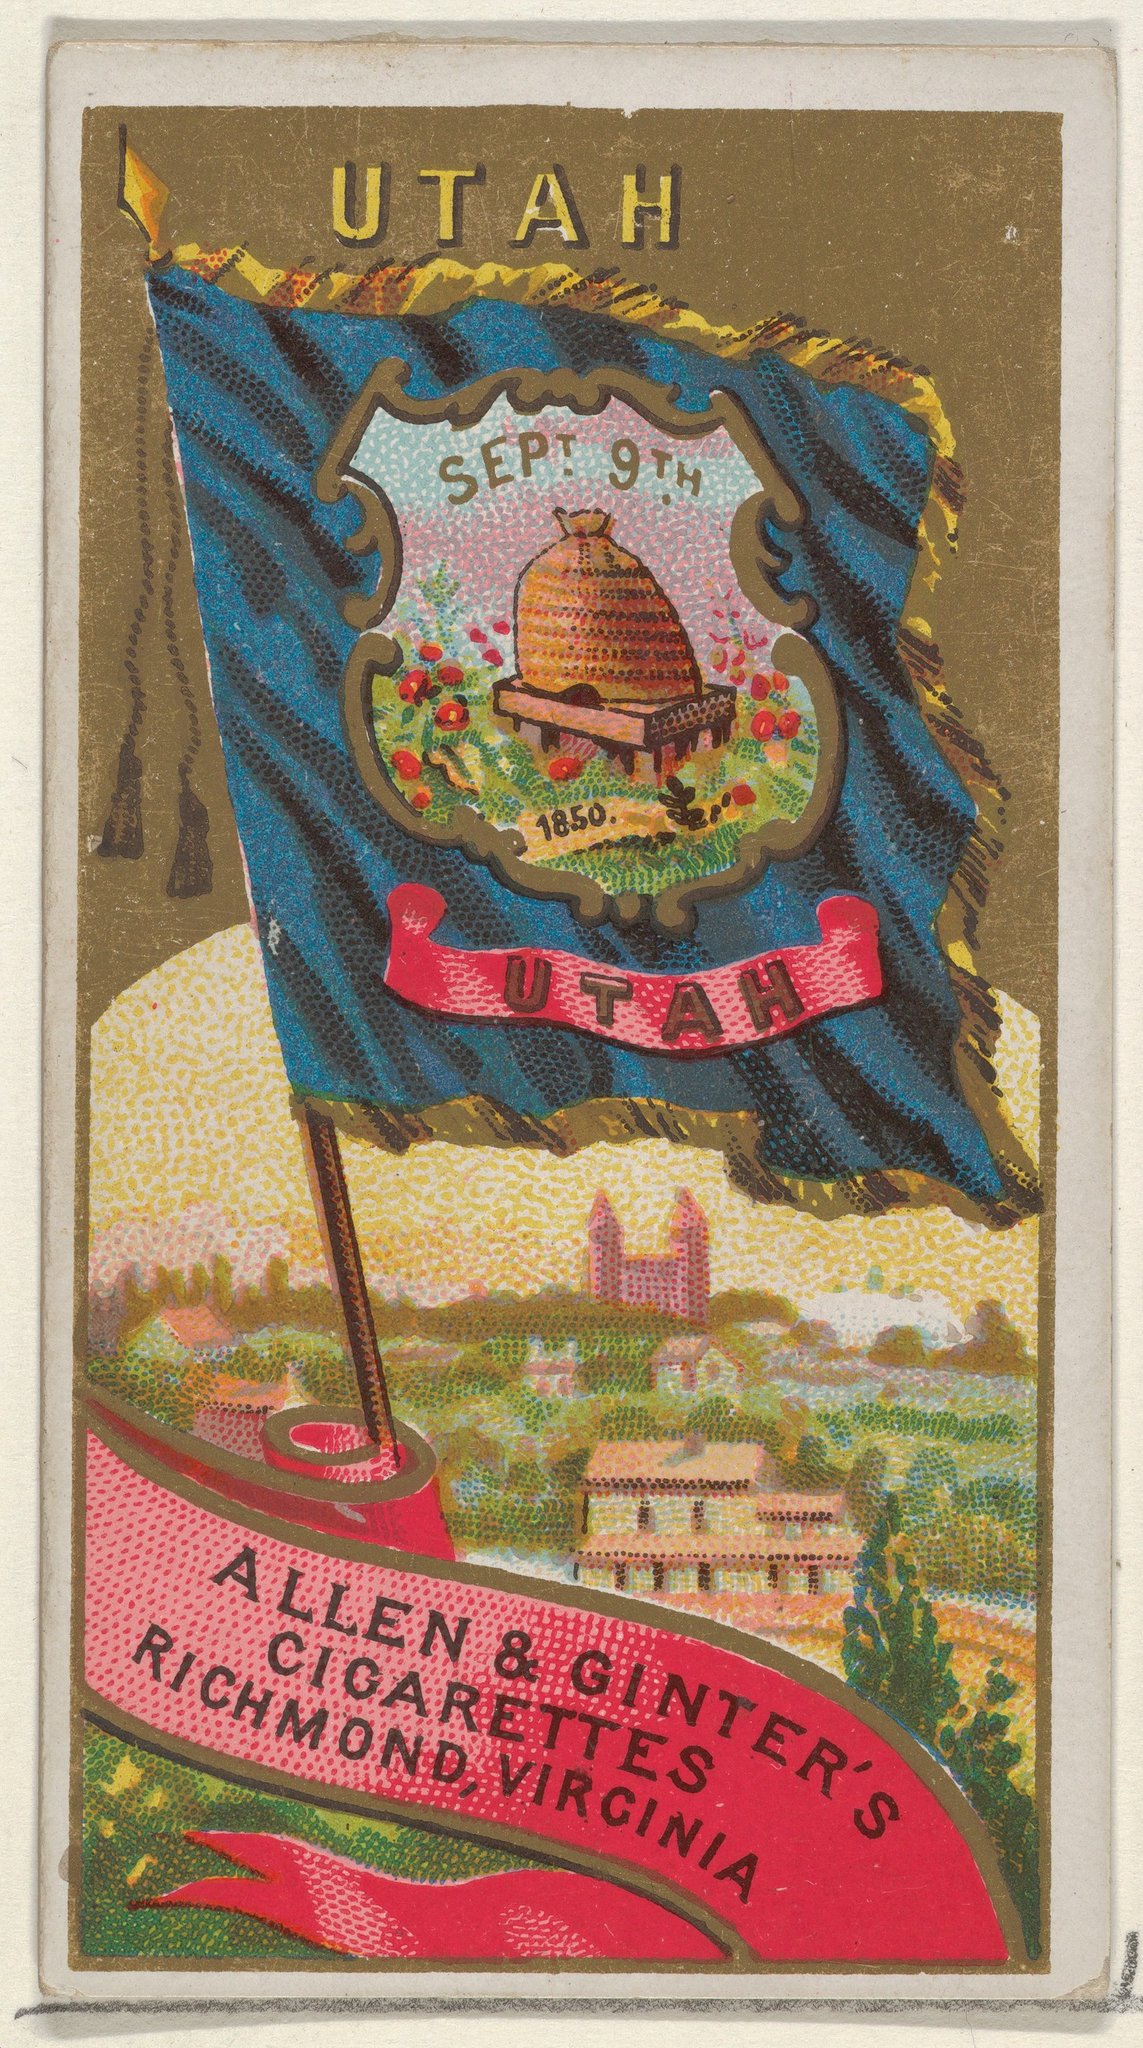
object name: print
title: Utah, from Flags of the States and Territories (N11) for Allen & Ginter Cigarettes Brands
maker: allen & ginter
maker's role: publisher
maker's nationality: american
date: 1888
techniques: color lithograph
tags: flags